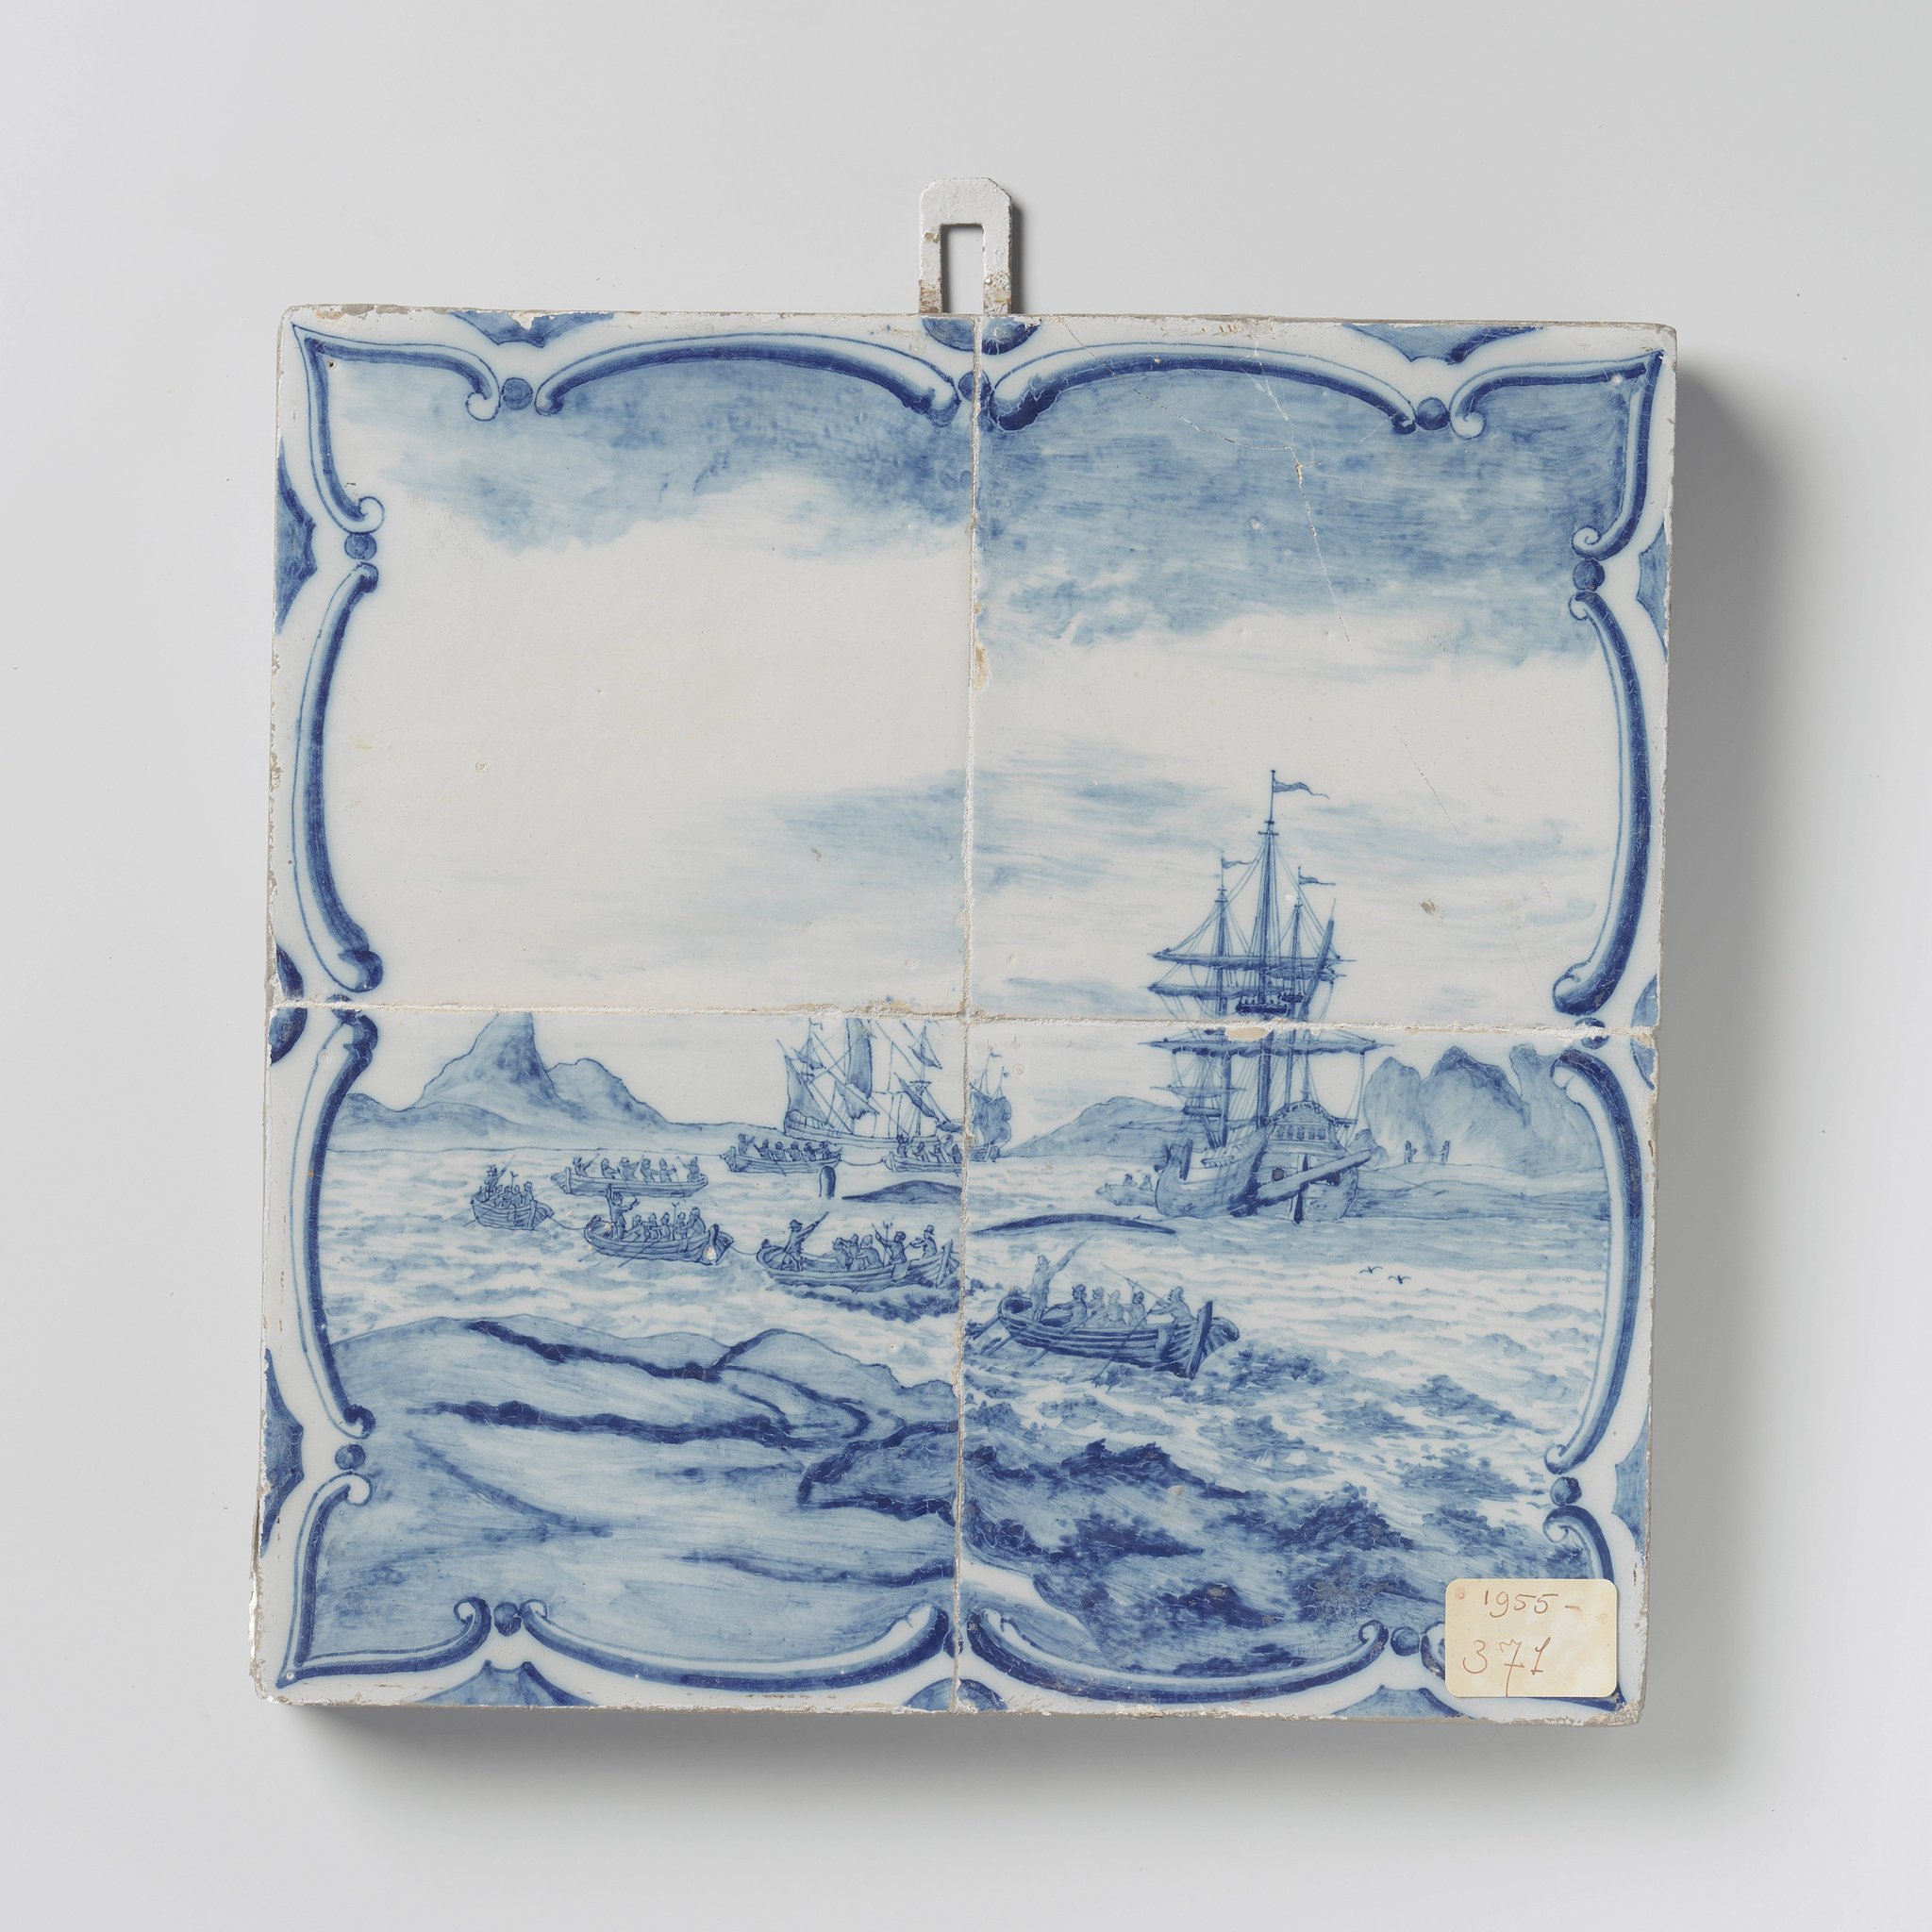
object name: tile tableau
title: Tegeltableau met zeegezicht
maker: Anonymous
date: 1725-1775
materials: earthenware, glaze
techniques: maiolica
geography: netherlands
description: Tegeltableau van vier tegels (2 x 2) met een blauw geschilderd zeegezicht met walvisvaarders: twee schepen en acht sloepen. Op de achtergrond, ijsbergen. De voorstelling is omlijst door een Franse accolade.